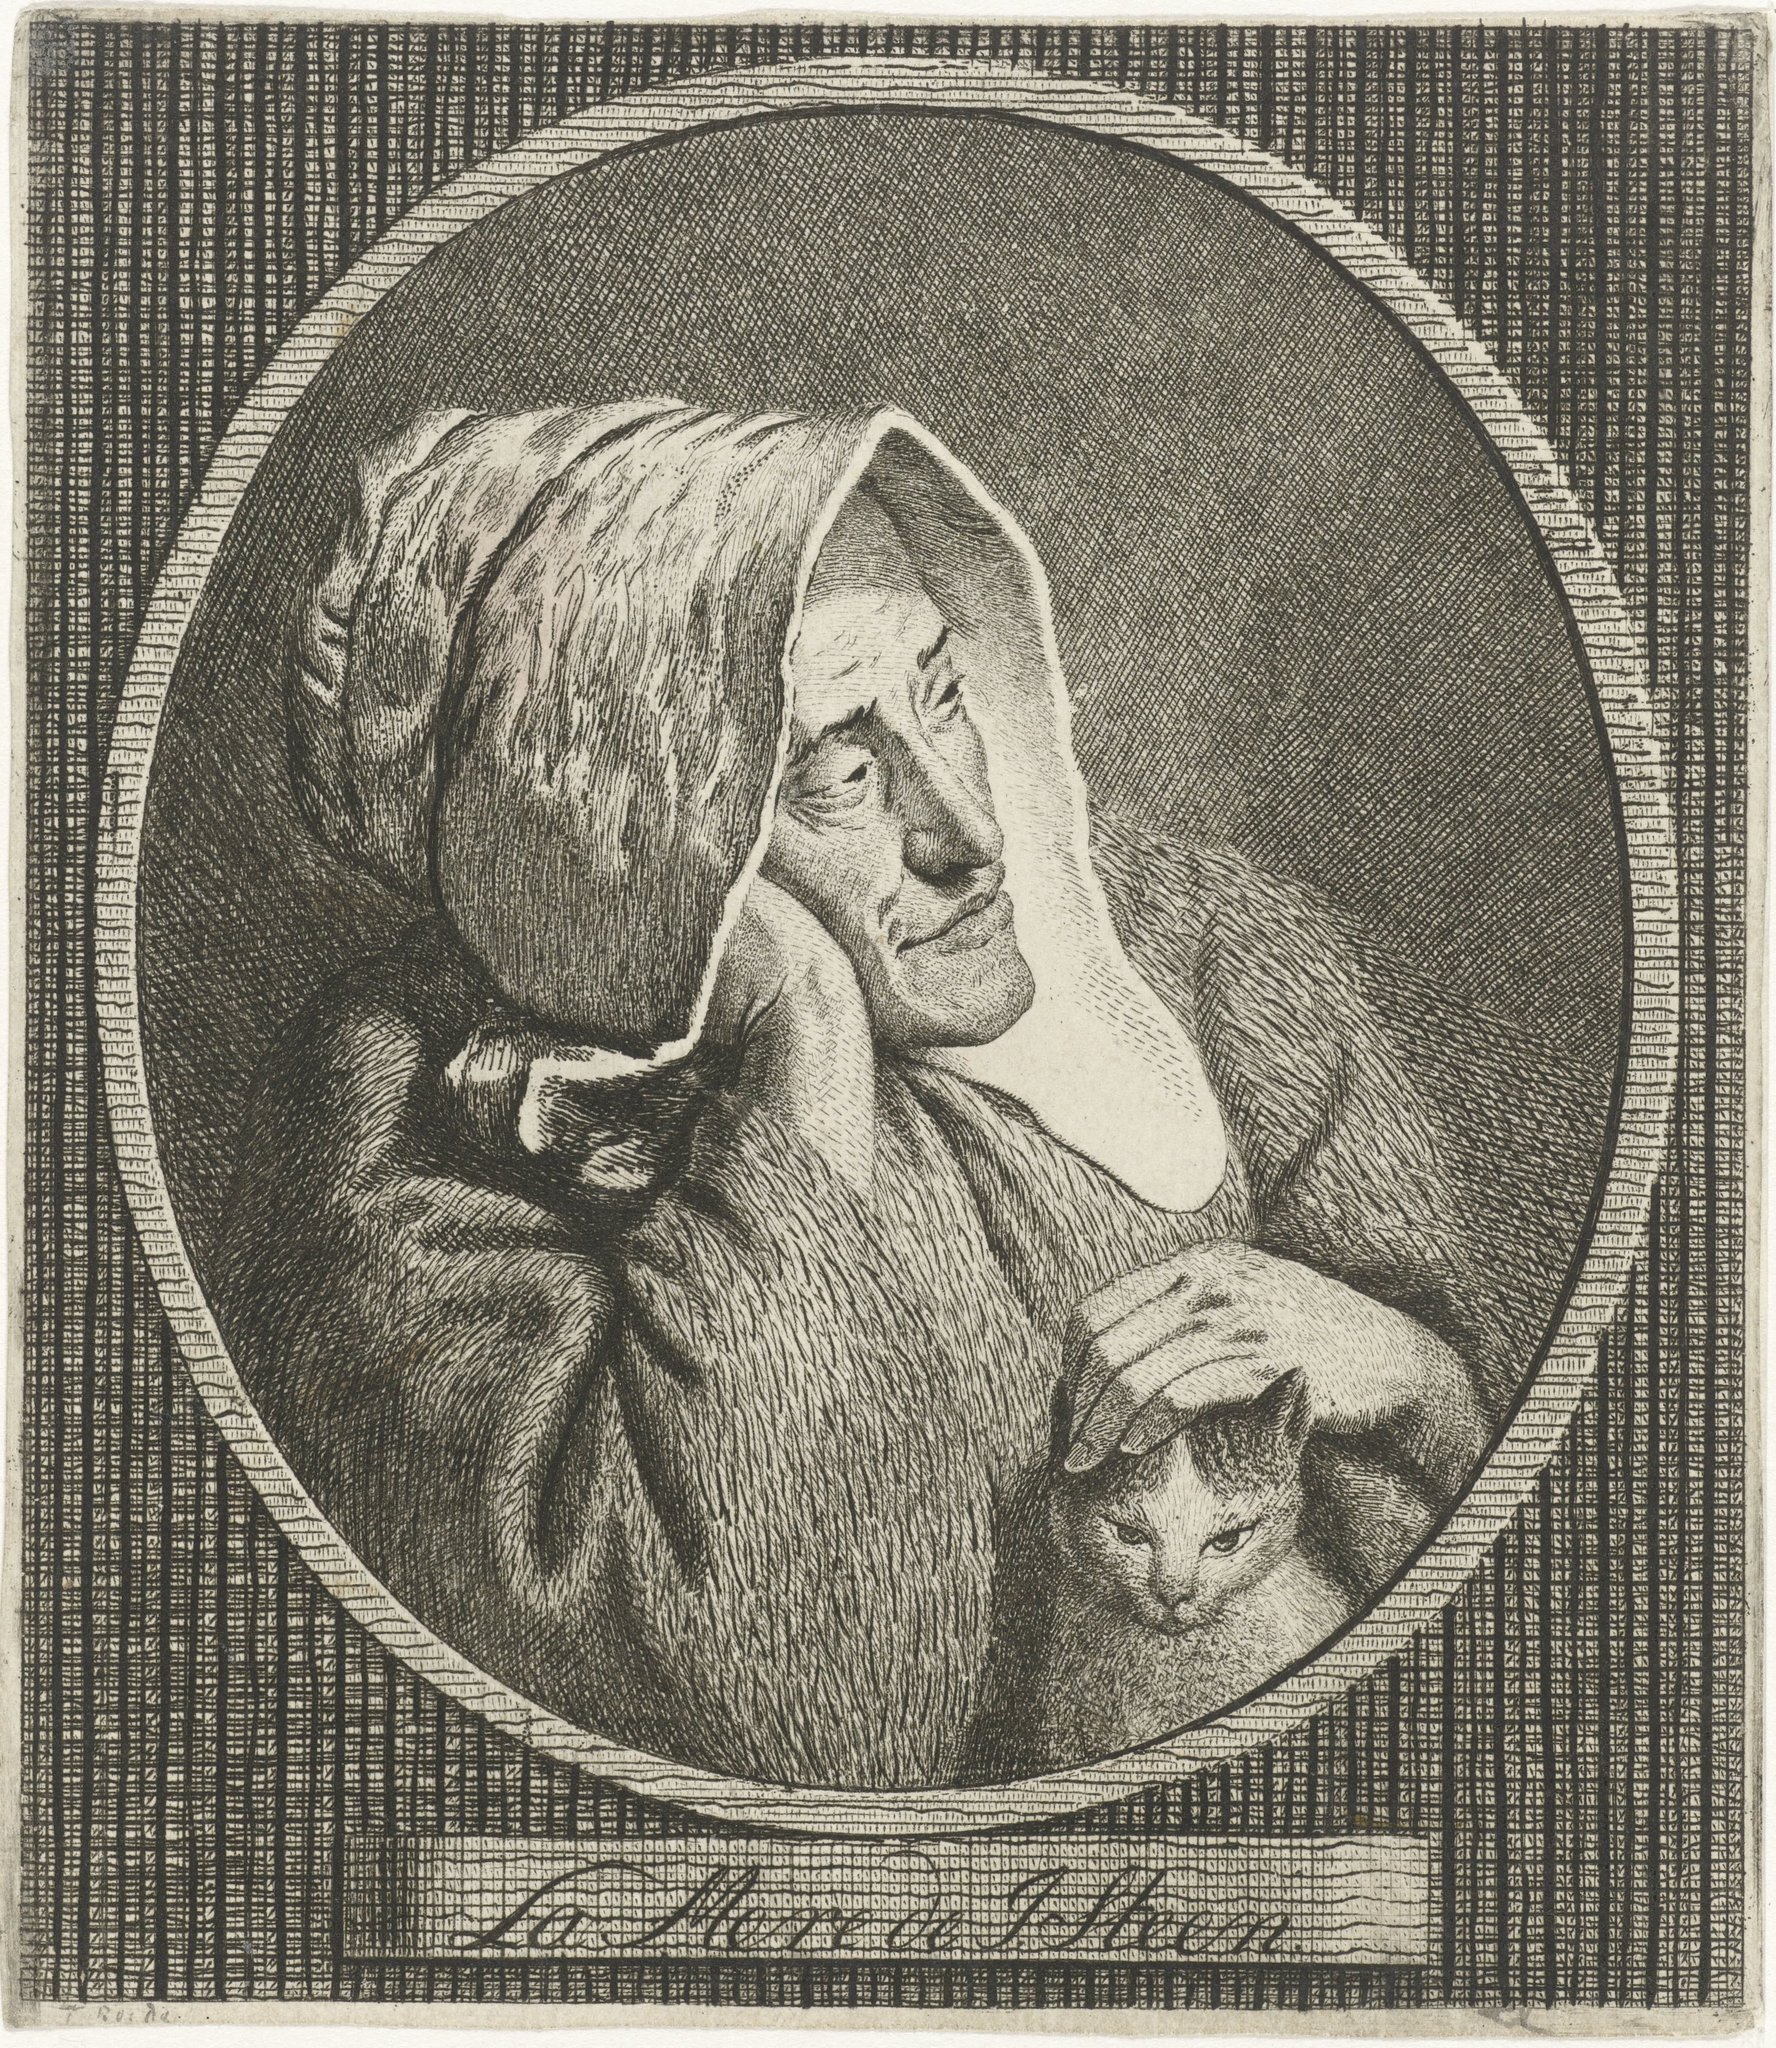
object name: print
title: La Mere de J. Steen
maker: theodorus de roode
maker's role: draughtsman, print maker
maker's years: 1736-1793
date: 1746-1793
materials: paper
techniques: engraving, etching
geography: netherlands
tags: cat, old woman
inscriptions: inscription: ‘T Roode’, collector's mark: Lugt 2228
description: Een oude vrouw, die met haar hoofd op haar hand leunt, streelt de kop van een kat.